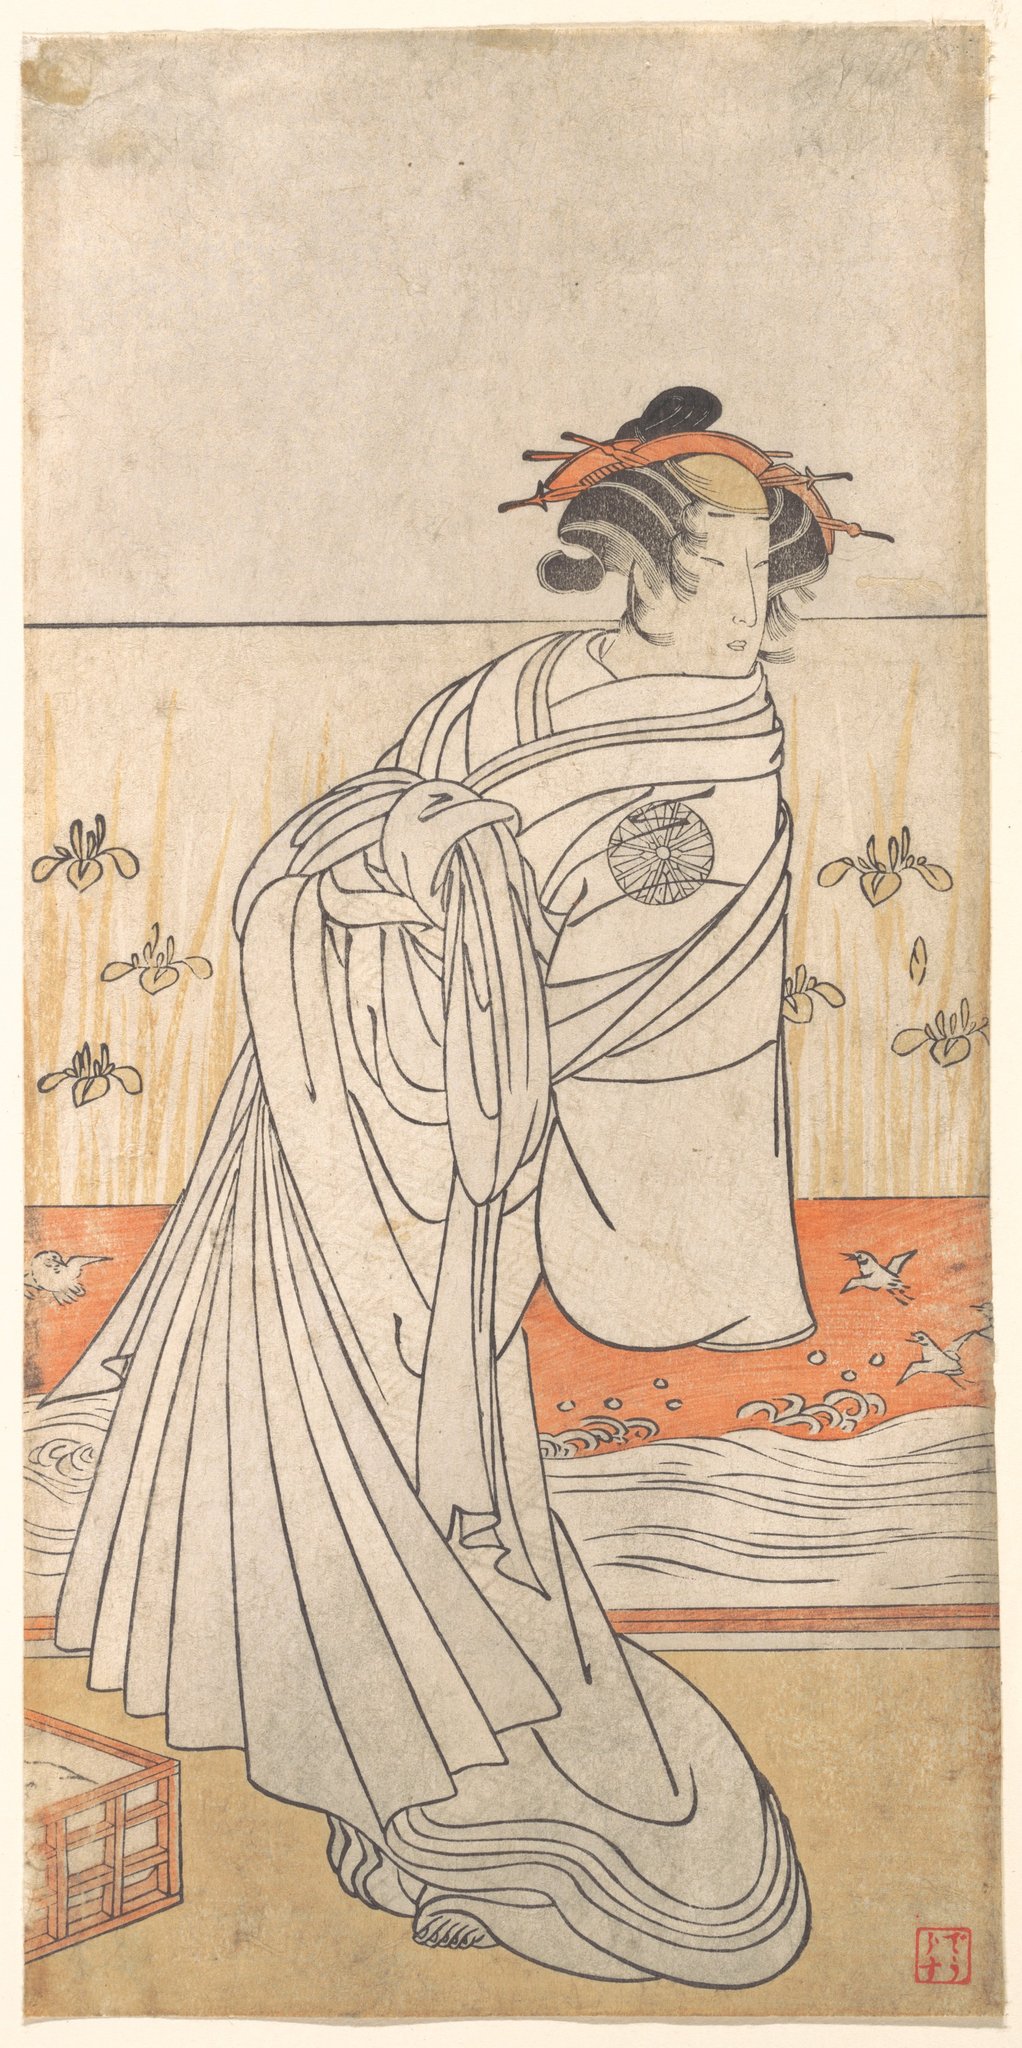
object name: print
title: Woman Standing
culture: japanese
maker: unidentified artist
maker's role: artist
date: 1615-1868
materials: ink, paper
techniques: woodblock print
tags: women